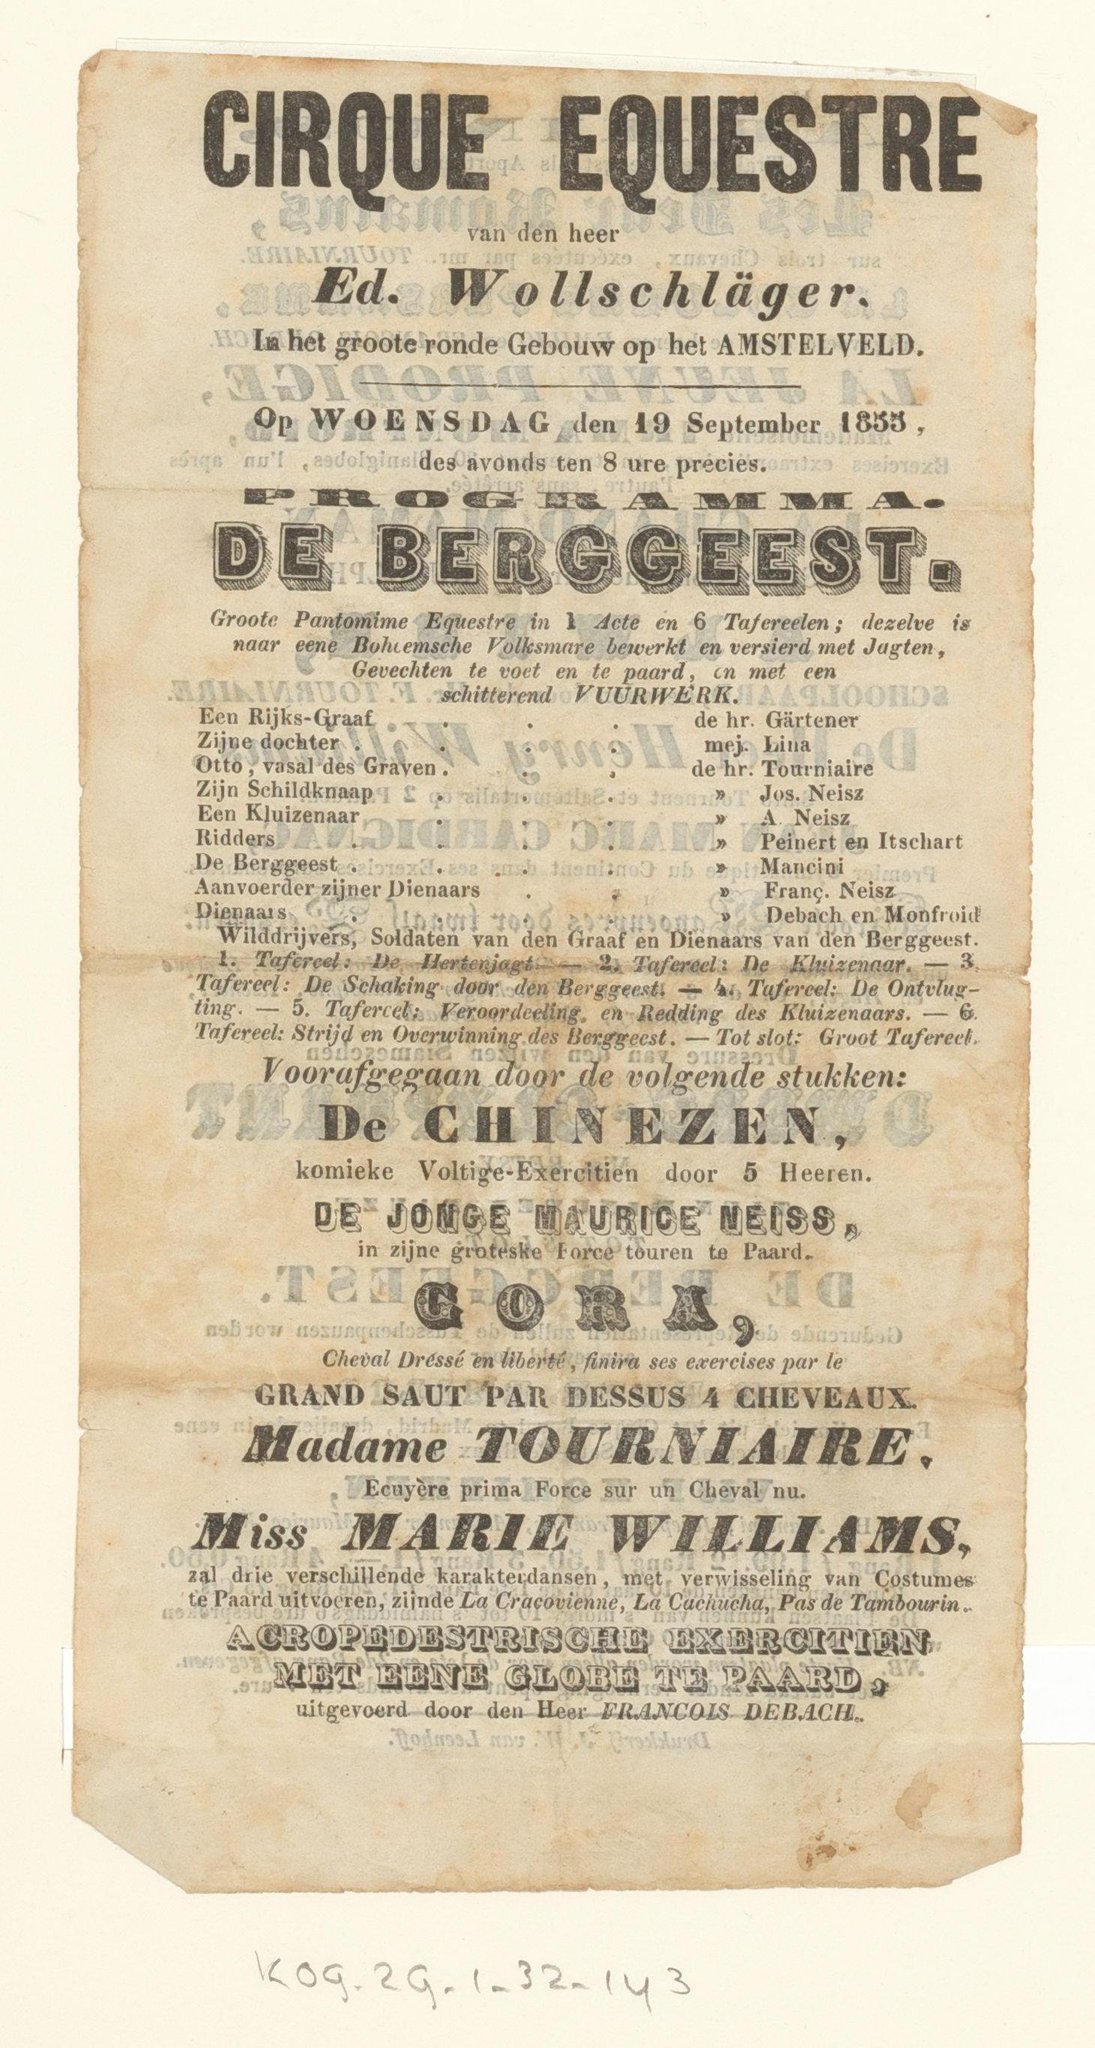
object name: text sheet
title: Cirque Equestre van den heer Ed. Wollschläger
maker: leenhoff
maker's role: printer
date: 1855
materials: paper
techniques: letterpress printing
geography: rotterdam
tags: pleasure fair and circus, horses (circus performance), amsterdam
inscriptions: collector's mark, collector's mark: Lugt 1641